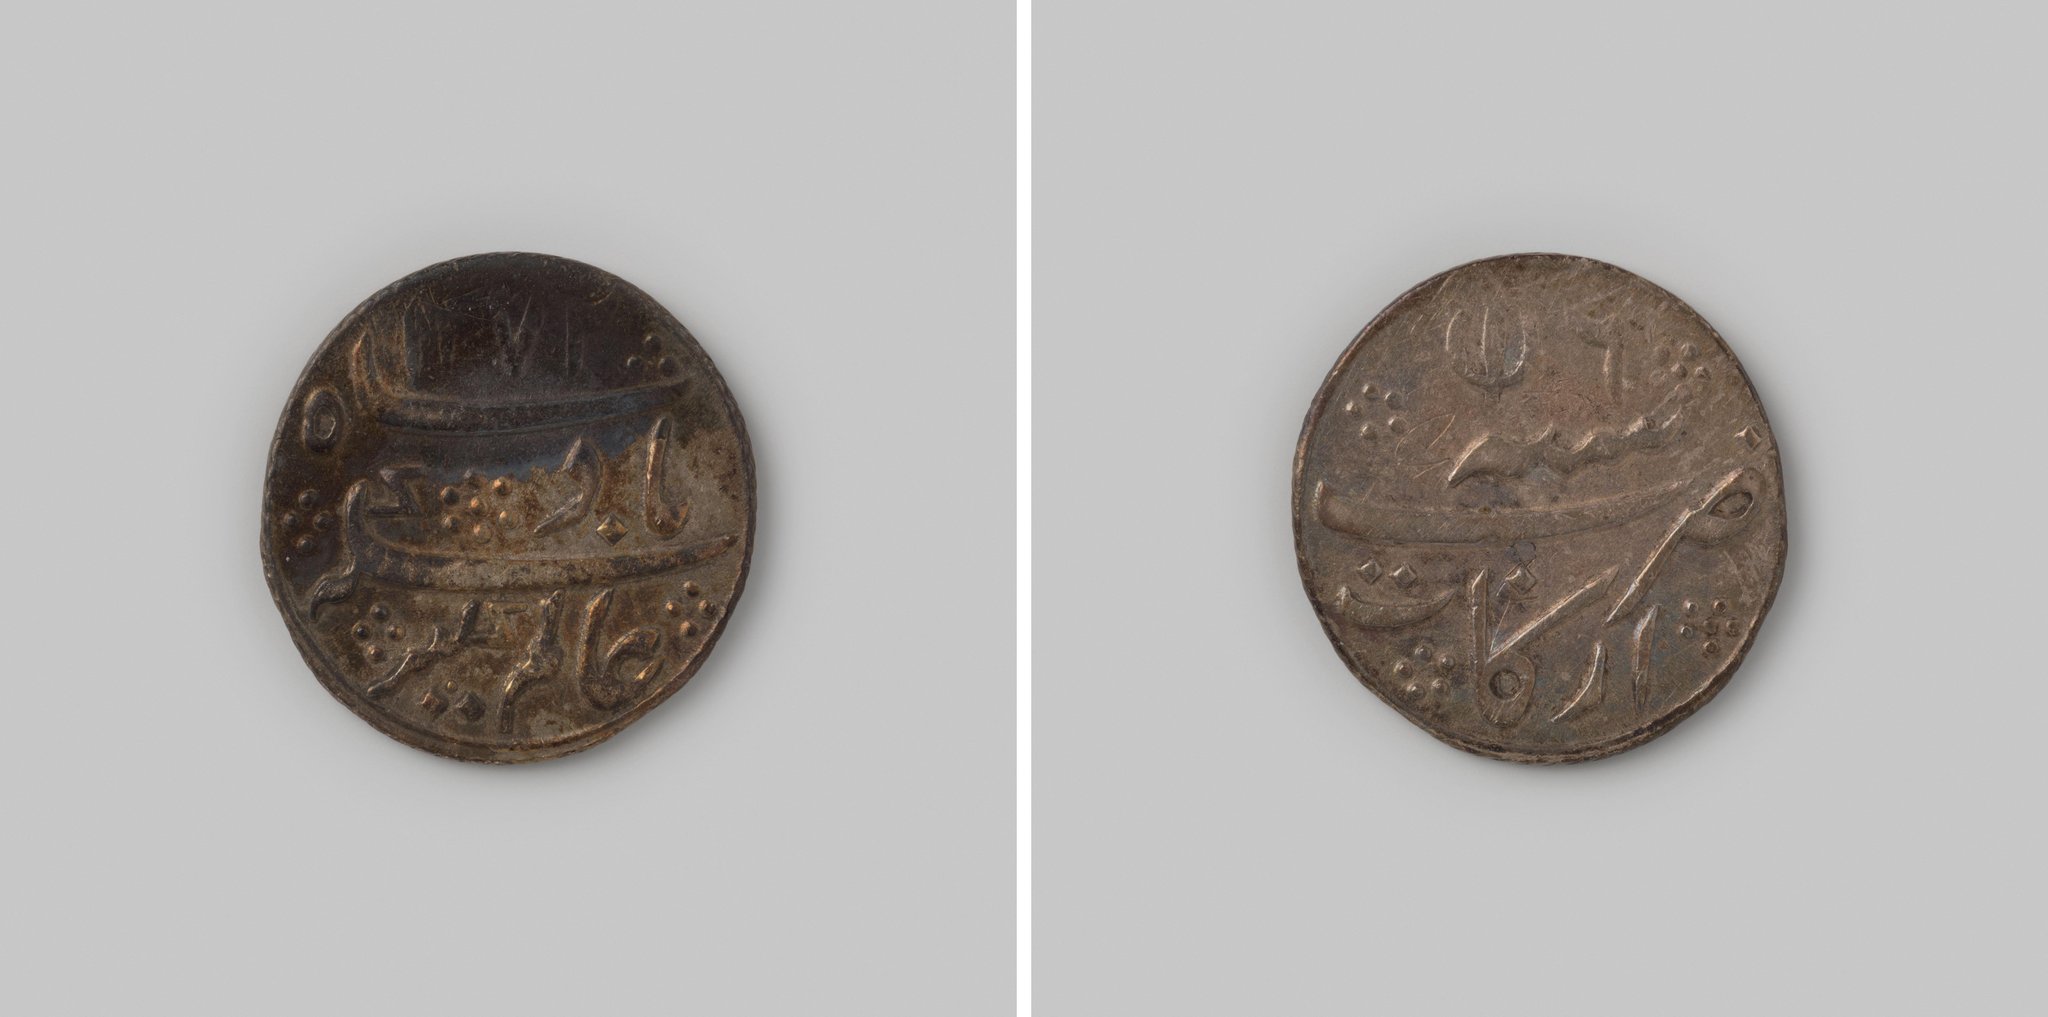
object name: coin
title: India, Engelse Oostindische Compagnie (EIC) , 1/4 arcot-roepie voor Madras, India, op naam van shah Alamgir II, (1807)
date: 1807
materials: silver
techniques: striking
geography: chennai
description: Zilveren munt. Voorzijde: opschrift in drie regels in Arabische lettertekens, waarin verwijzing naar shah Alamgir II. Bovenaan "bevroren" jaartal: 1172. Keerzijde: opschrift in drie regels in Arabische lettertekens. Bovenaan rechts aanduiding regeringsjaar: 6 en daarnaast lotusbloem. Kabelrand.